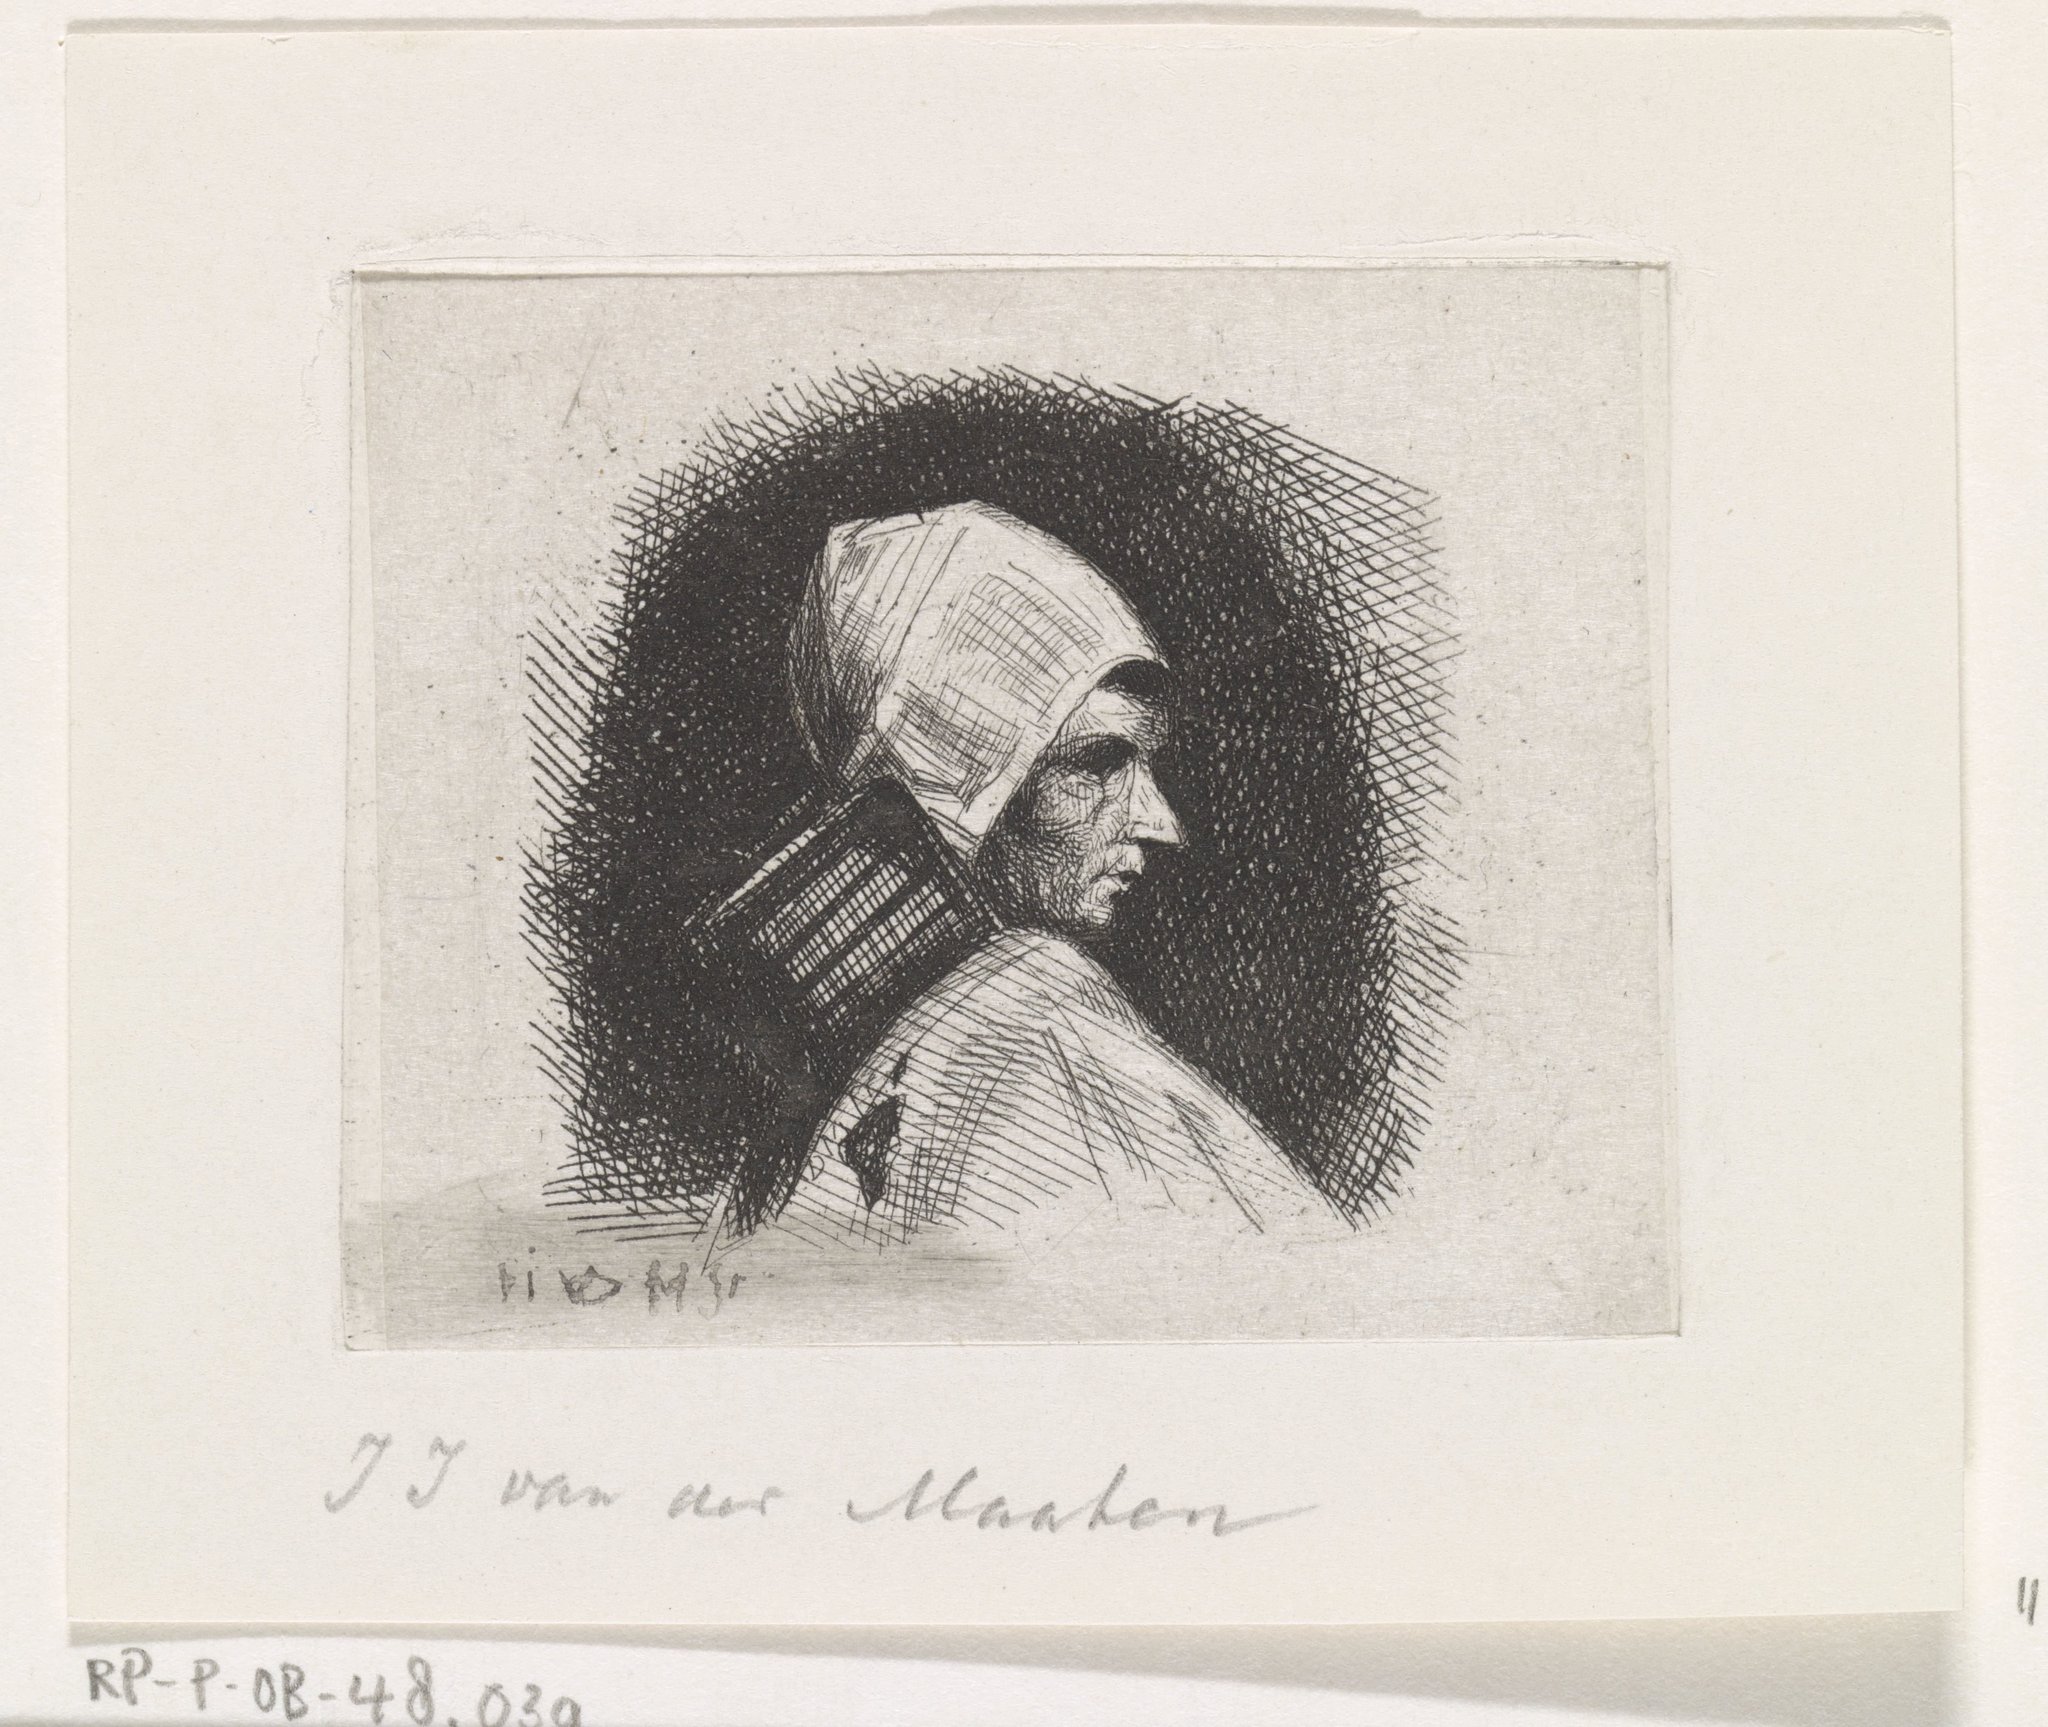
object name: print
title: Buste van een vrouw naar rechts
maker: jacob jan van der maaten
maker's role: draughtsman, print maker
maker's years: 1820-1879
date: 1830-1879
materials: paper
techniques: etching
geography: netherlands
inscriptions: name: ‘JJ cvan der Maaten’, collector's mark: Lugt 2228